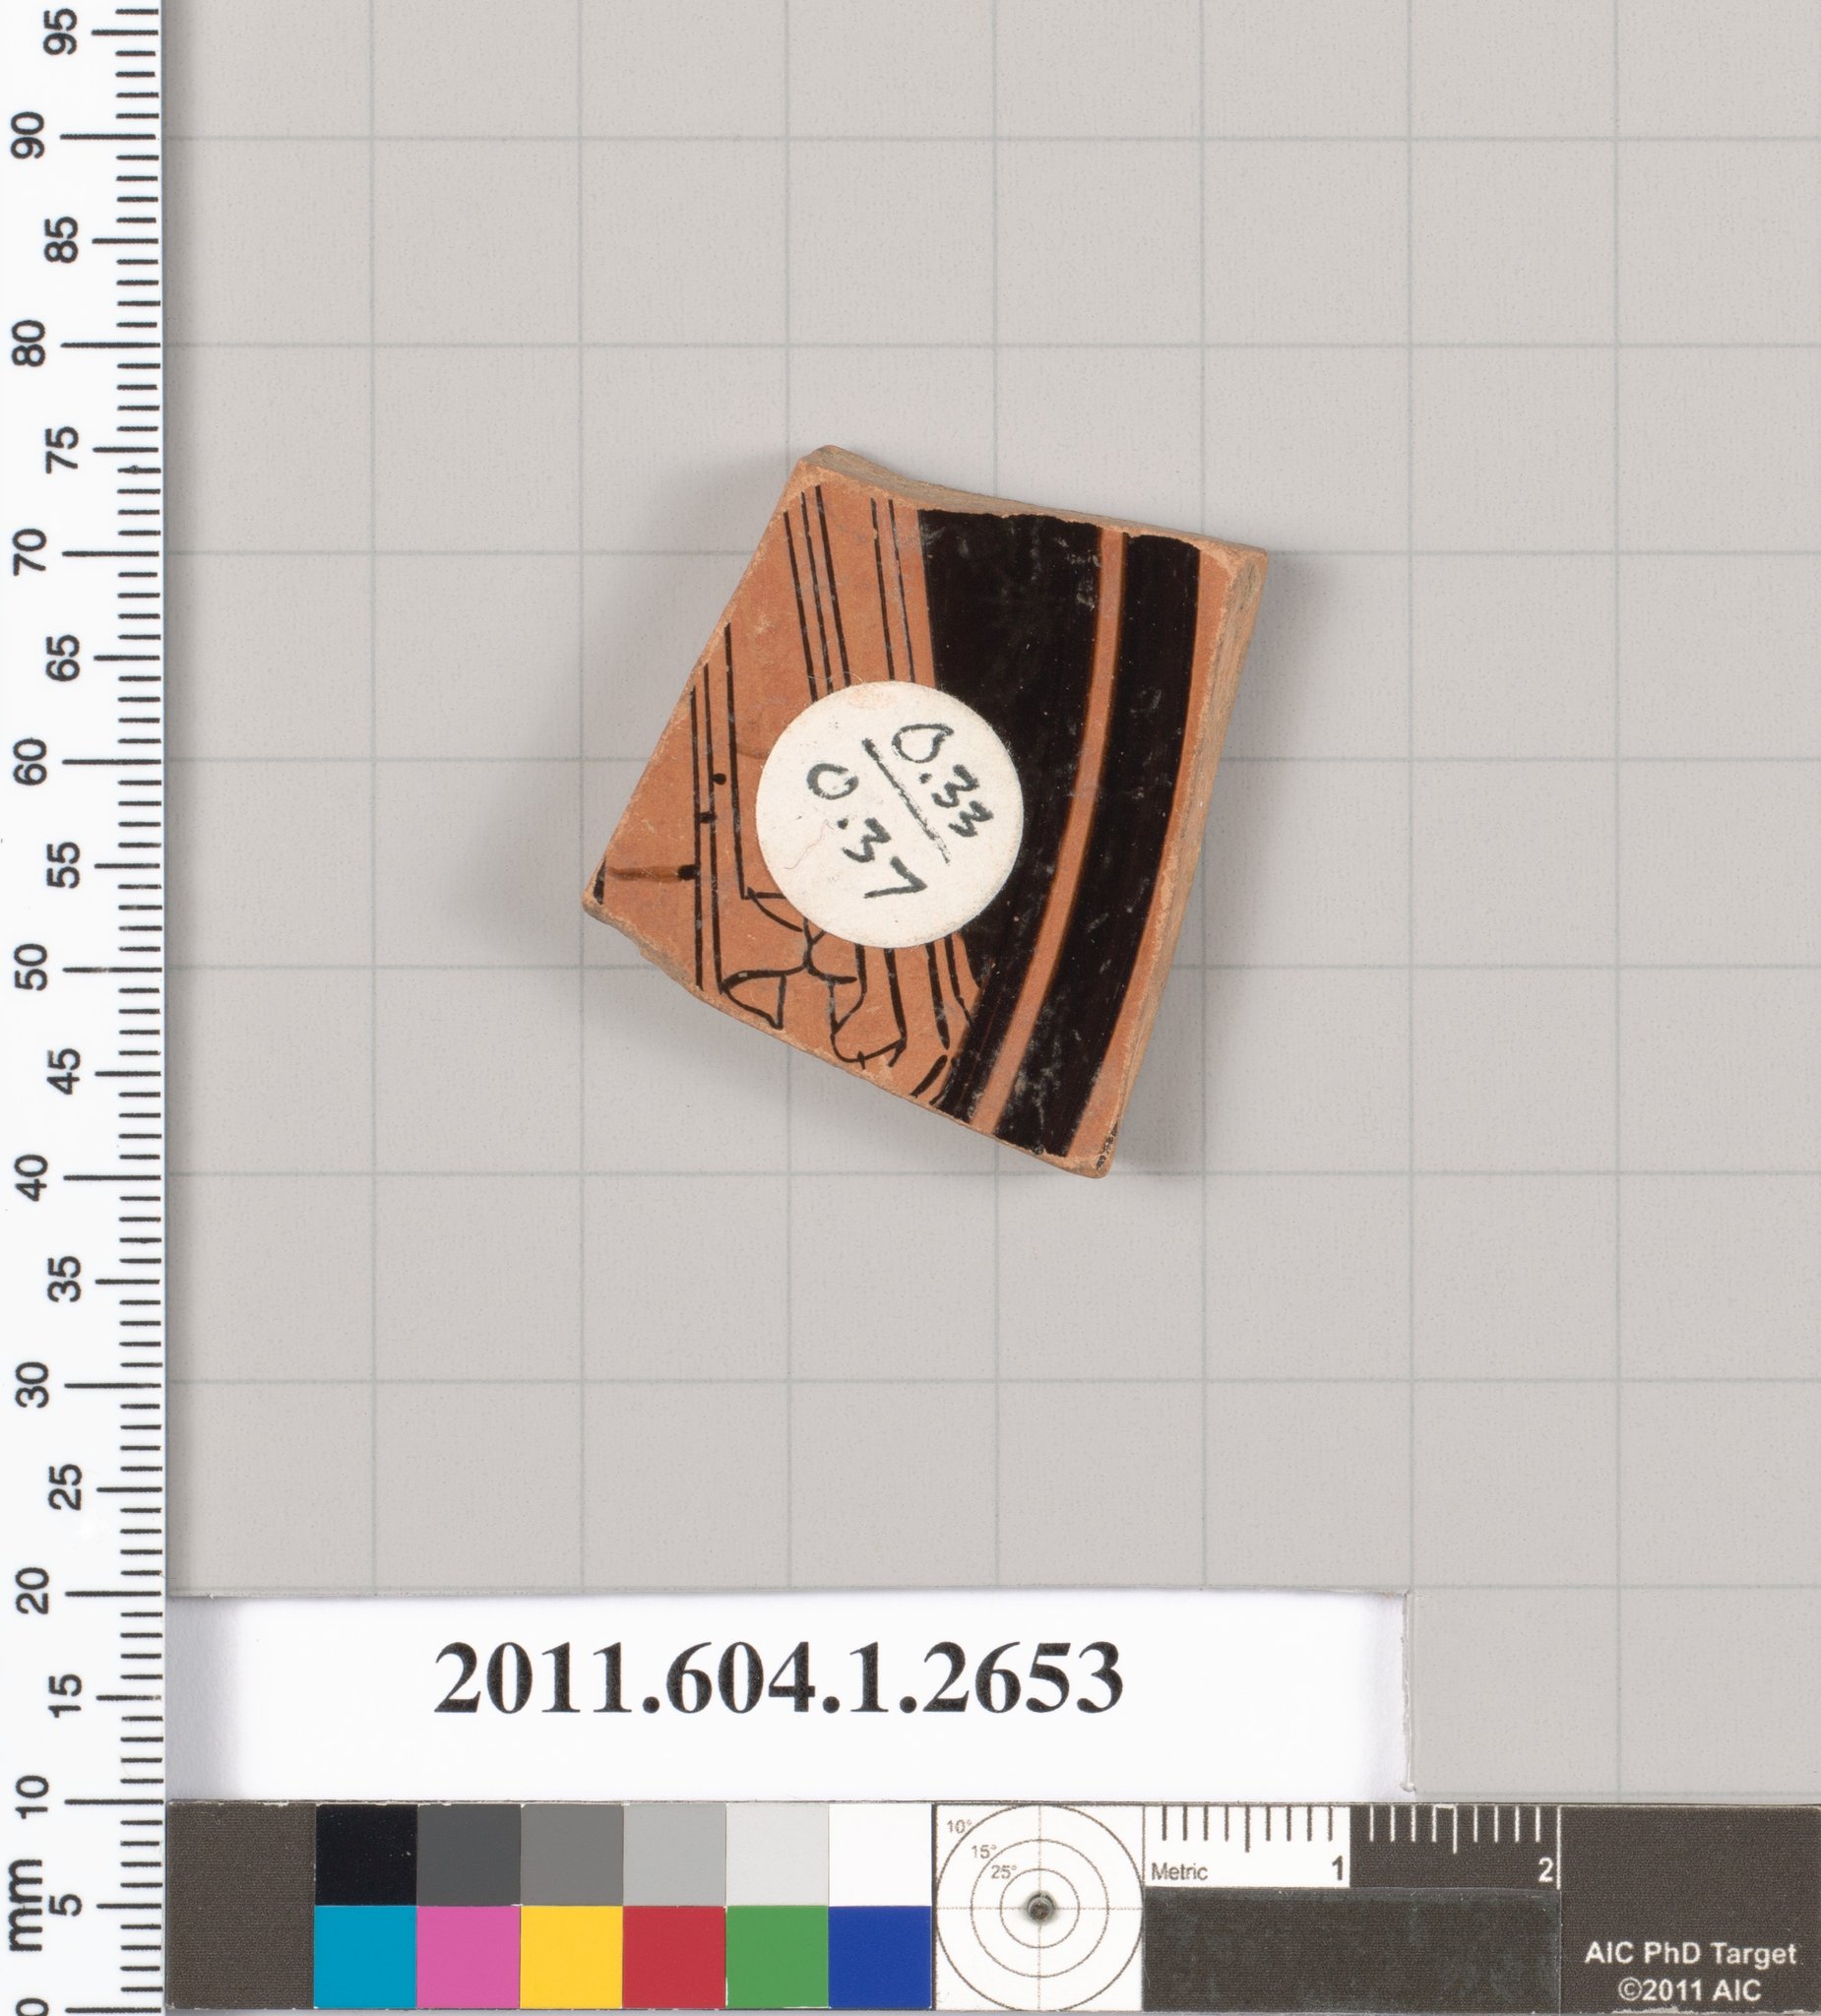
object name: kylix fragment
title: Terracotta fragment of a kylix (drinking cup)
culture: greek, attic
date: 490-480 BCE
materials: terracotta